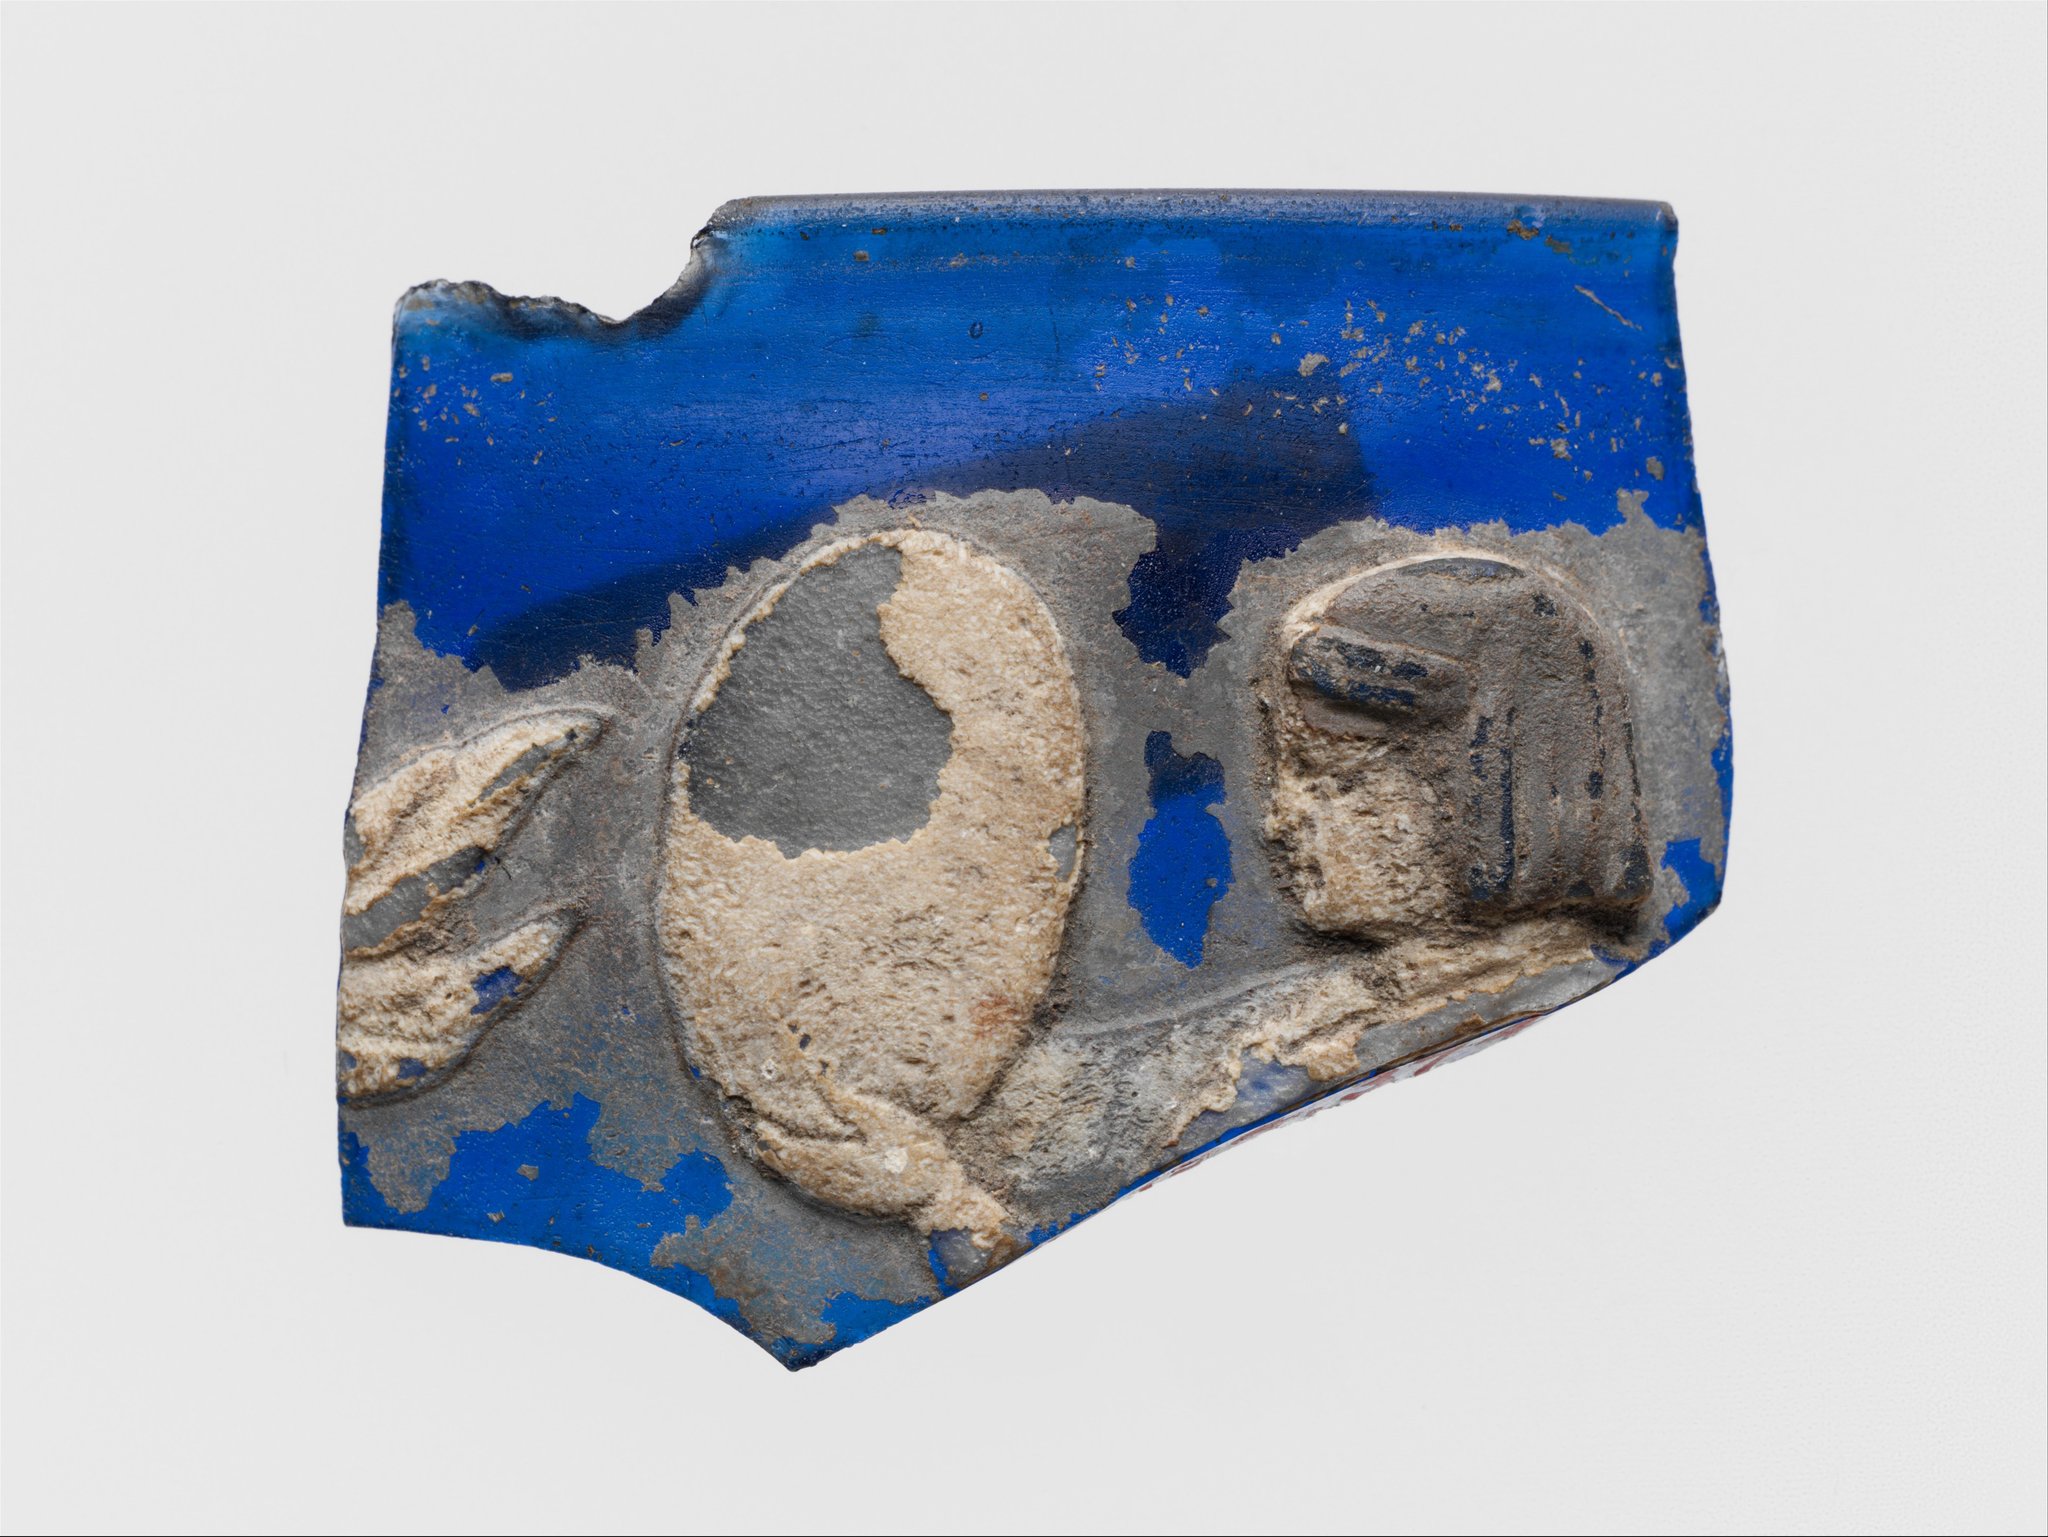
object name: cameo, cup fragment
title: Glass cameo cup fragment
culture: roman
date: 1-33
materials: glass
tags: heads